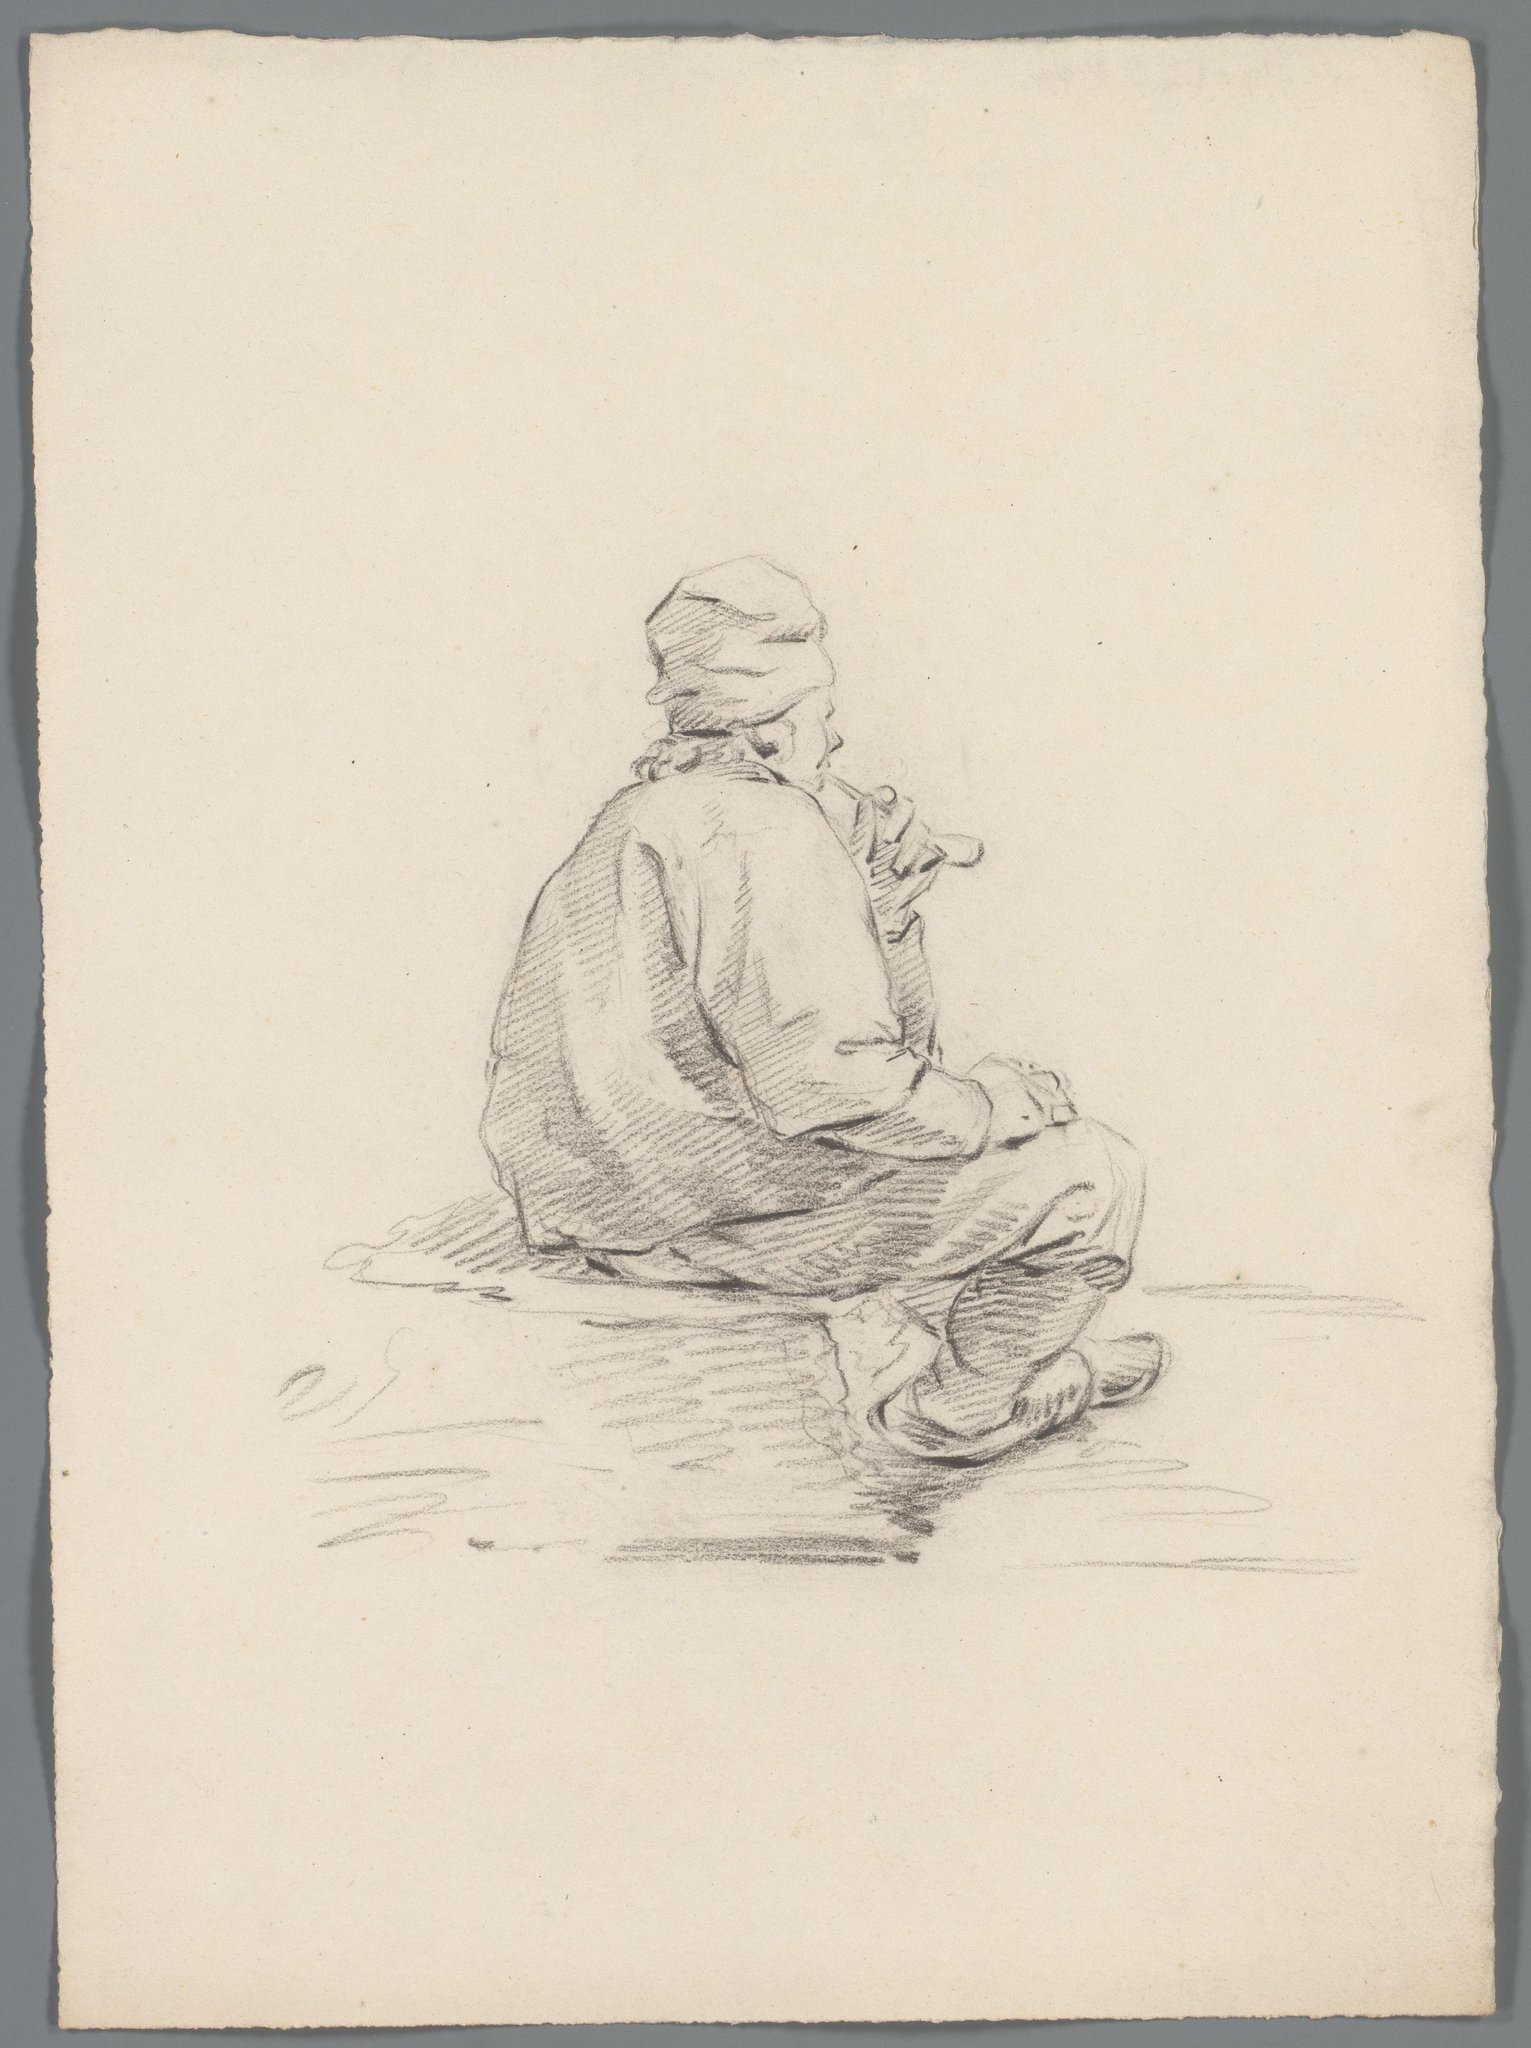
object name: drawing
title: Zittende man met pijp, op de rug gezien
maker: Anonymous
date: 1820-1830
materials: chalk, paper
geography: the hague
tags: sitting figure, adult man, pipe ~ tobacco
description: Tekeningen waarschijnlijk ontstaan bij het Haagse kunstgenootschap ‘Tot Nut der Tekenkunst’, waar twee keer per week tekenavonden werden georganiseerd met geklede modellen.